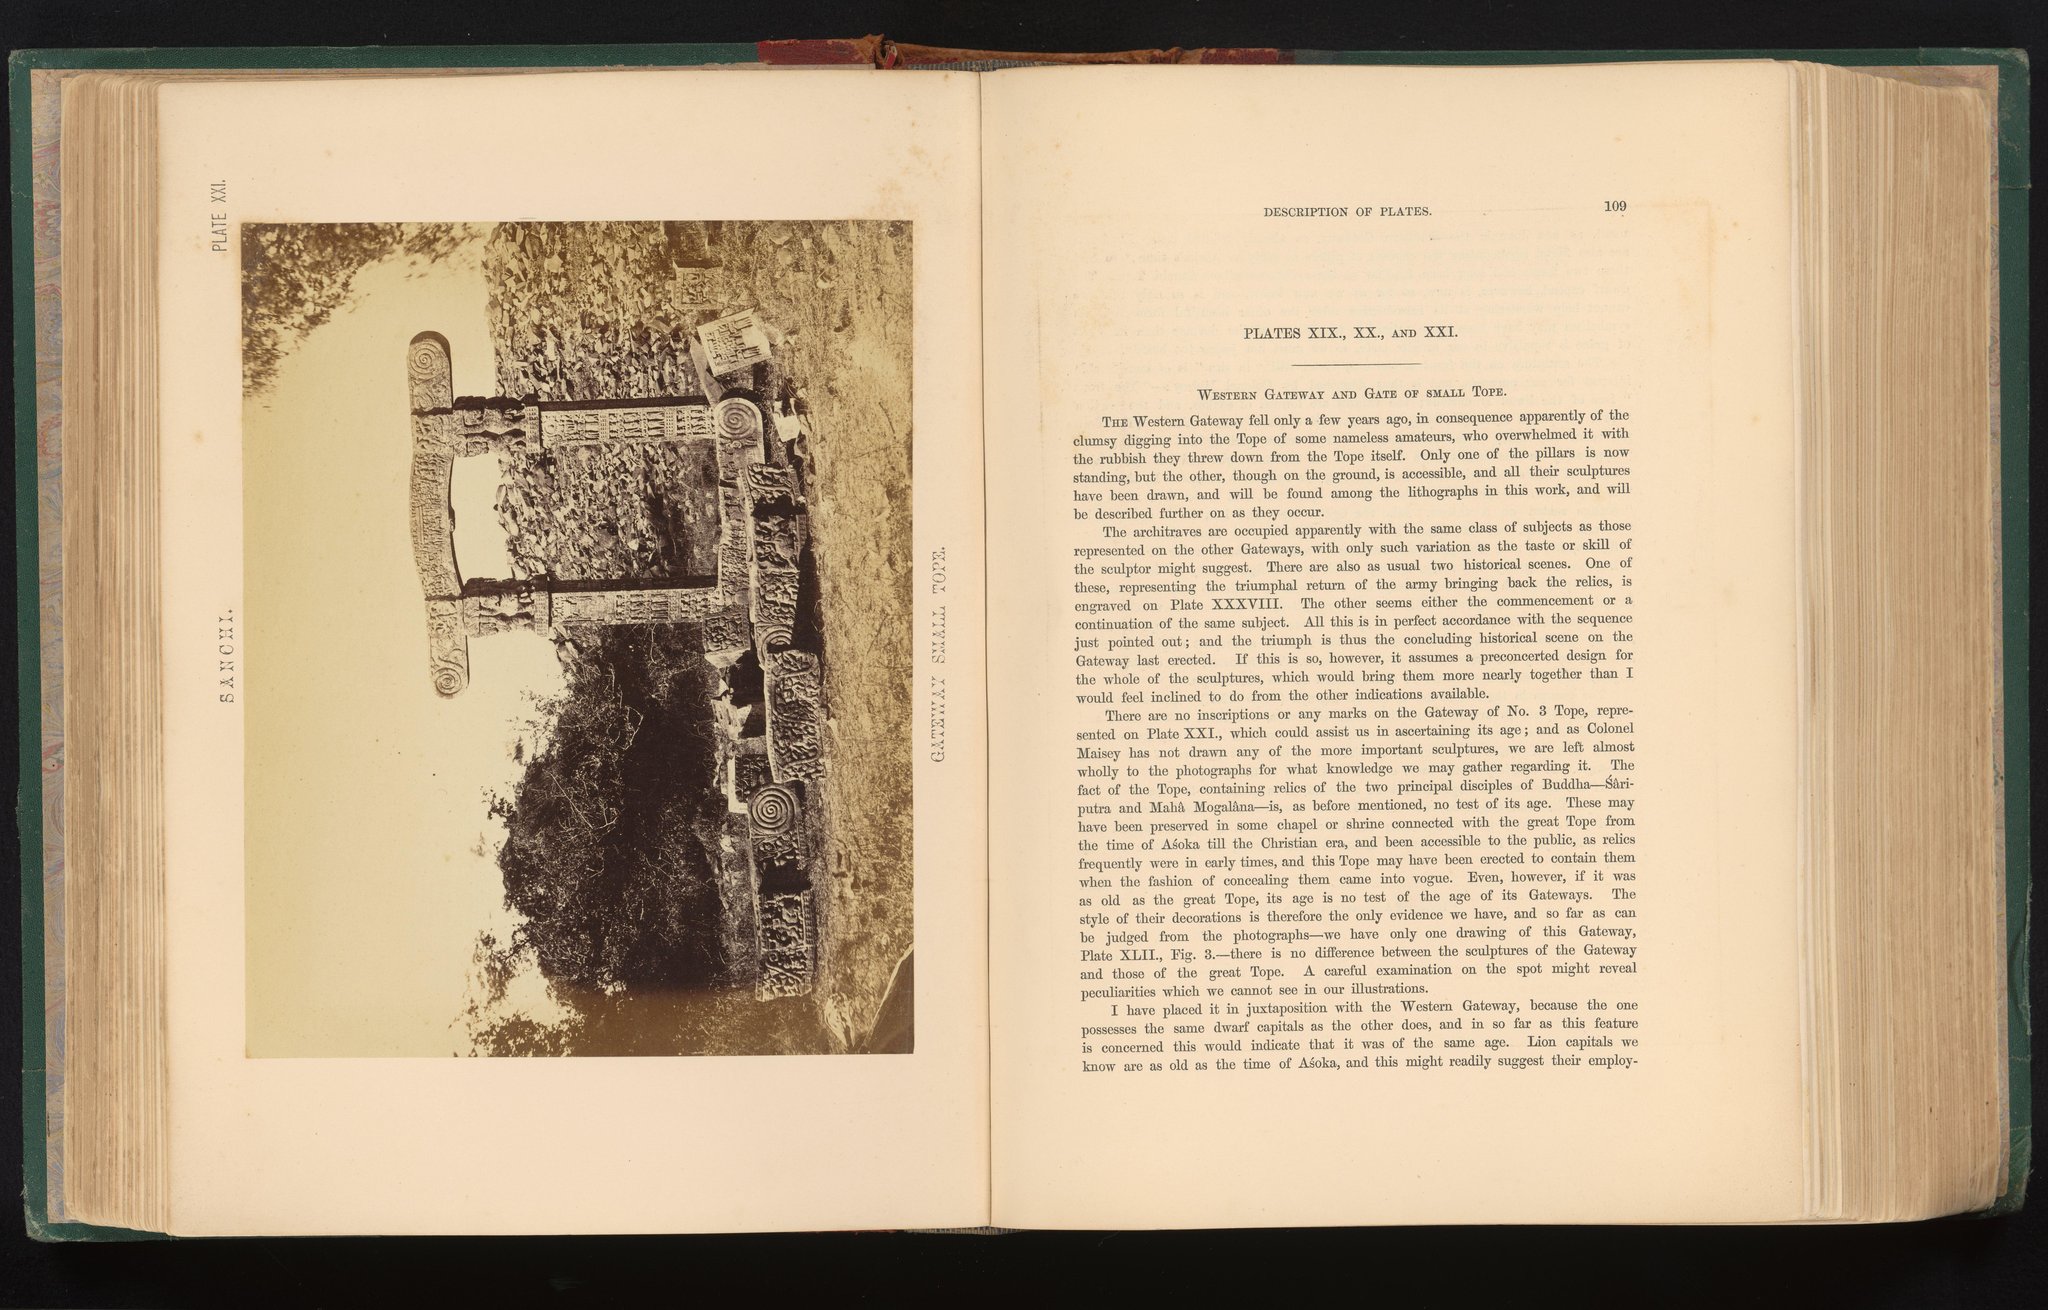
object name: page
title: Small gateway (torana) by the Great Stupa at Sanchi, Madhya Pradesh, India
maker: james john waterhouse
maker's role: fotograaf, luitenant, officier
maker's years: 1842-1928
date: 1863-1868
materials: photographic support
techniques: albumen print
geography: sanchi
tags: places and objects of worship ~ hinduism, buddhism, jainism, gate, entrance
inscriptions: inscription: ‘SANCHI. PLATE XXI./ GATEWAY SMALL TOPE.’